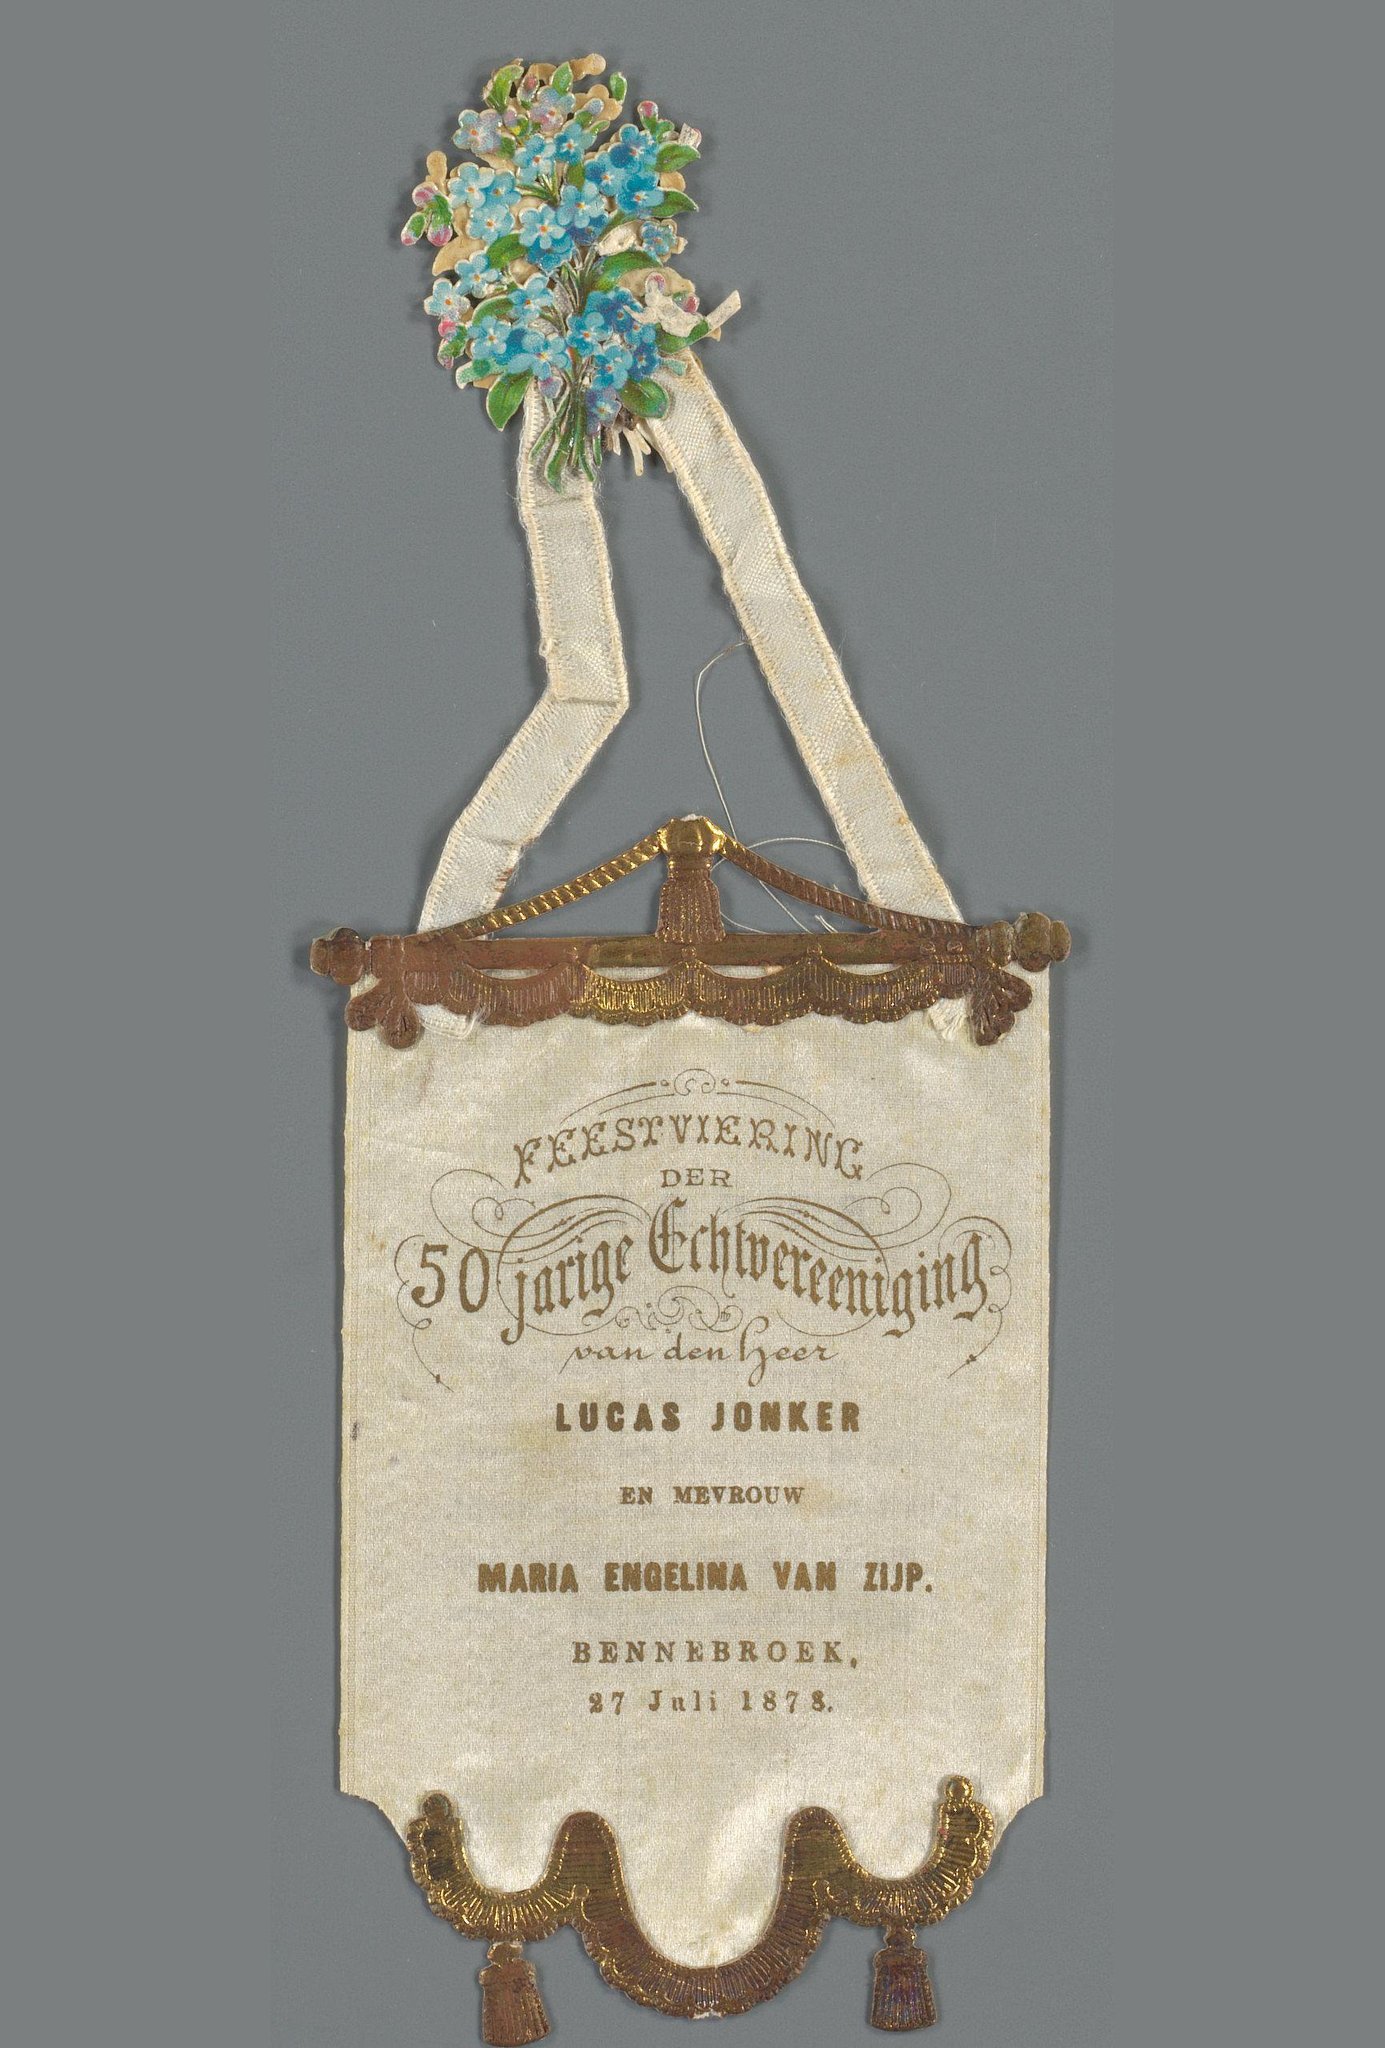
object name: marriage print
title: Souvenir bij het gouden huwelijksjubileum van Lucas Jonker en Maria Engelina Jonker van Zijp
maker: Anonymous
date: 1878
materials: paper, silk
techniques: chromolithography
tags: cut flowers; nosegay, bunch of flowers, marriage, married couple, 'matrimonium', banner, standard (as symbol of the state, etc.)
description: Klein vaandel met daarop de tekst: 'Feestviering der 50jarige Echtvereeniging van den Heer Lucas Jonker en Mevrouw Maria Engelina van Zijp. Bennebroek, 27 Juli 1878'. Op de achterzijde nog de tekst van het refrein van een lied (op de wijs van Henri's Drinklied). Bovenaan een bosje bloemen.